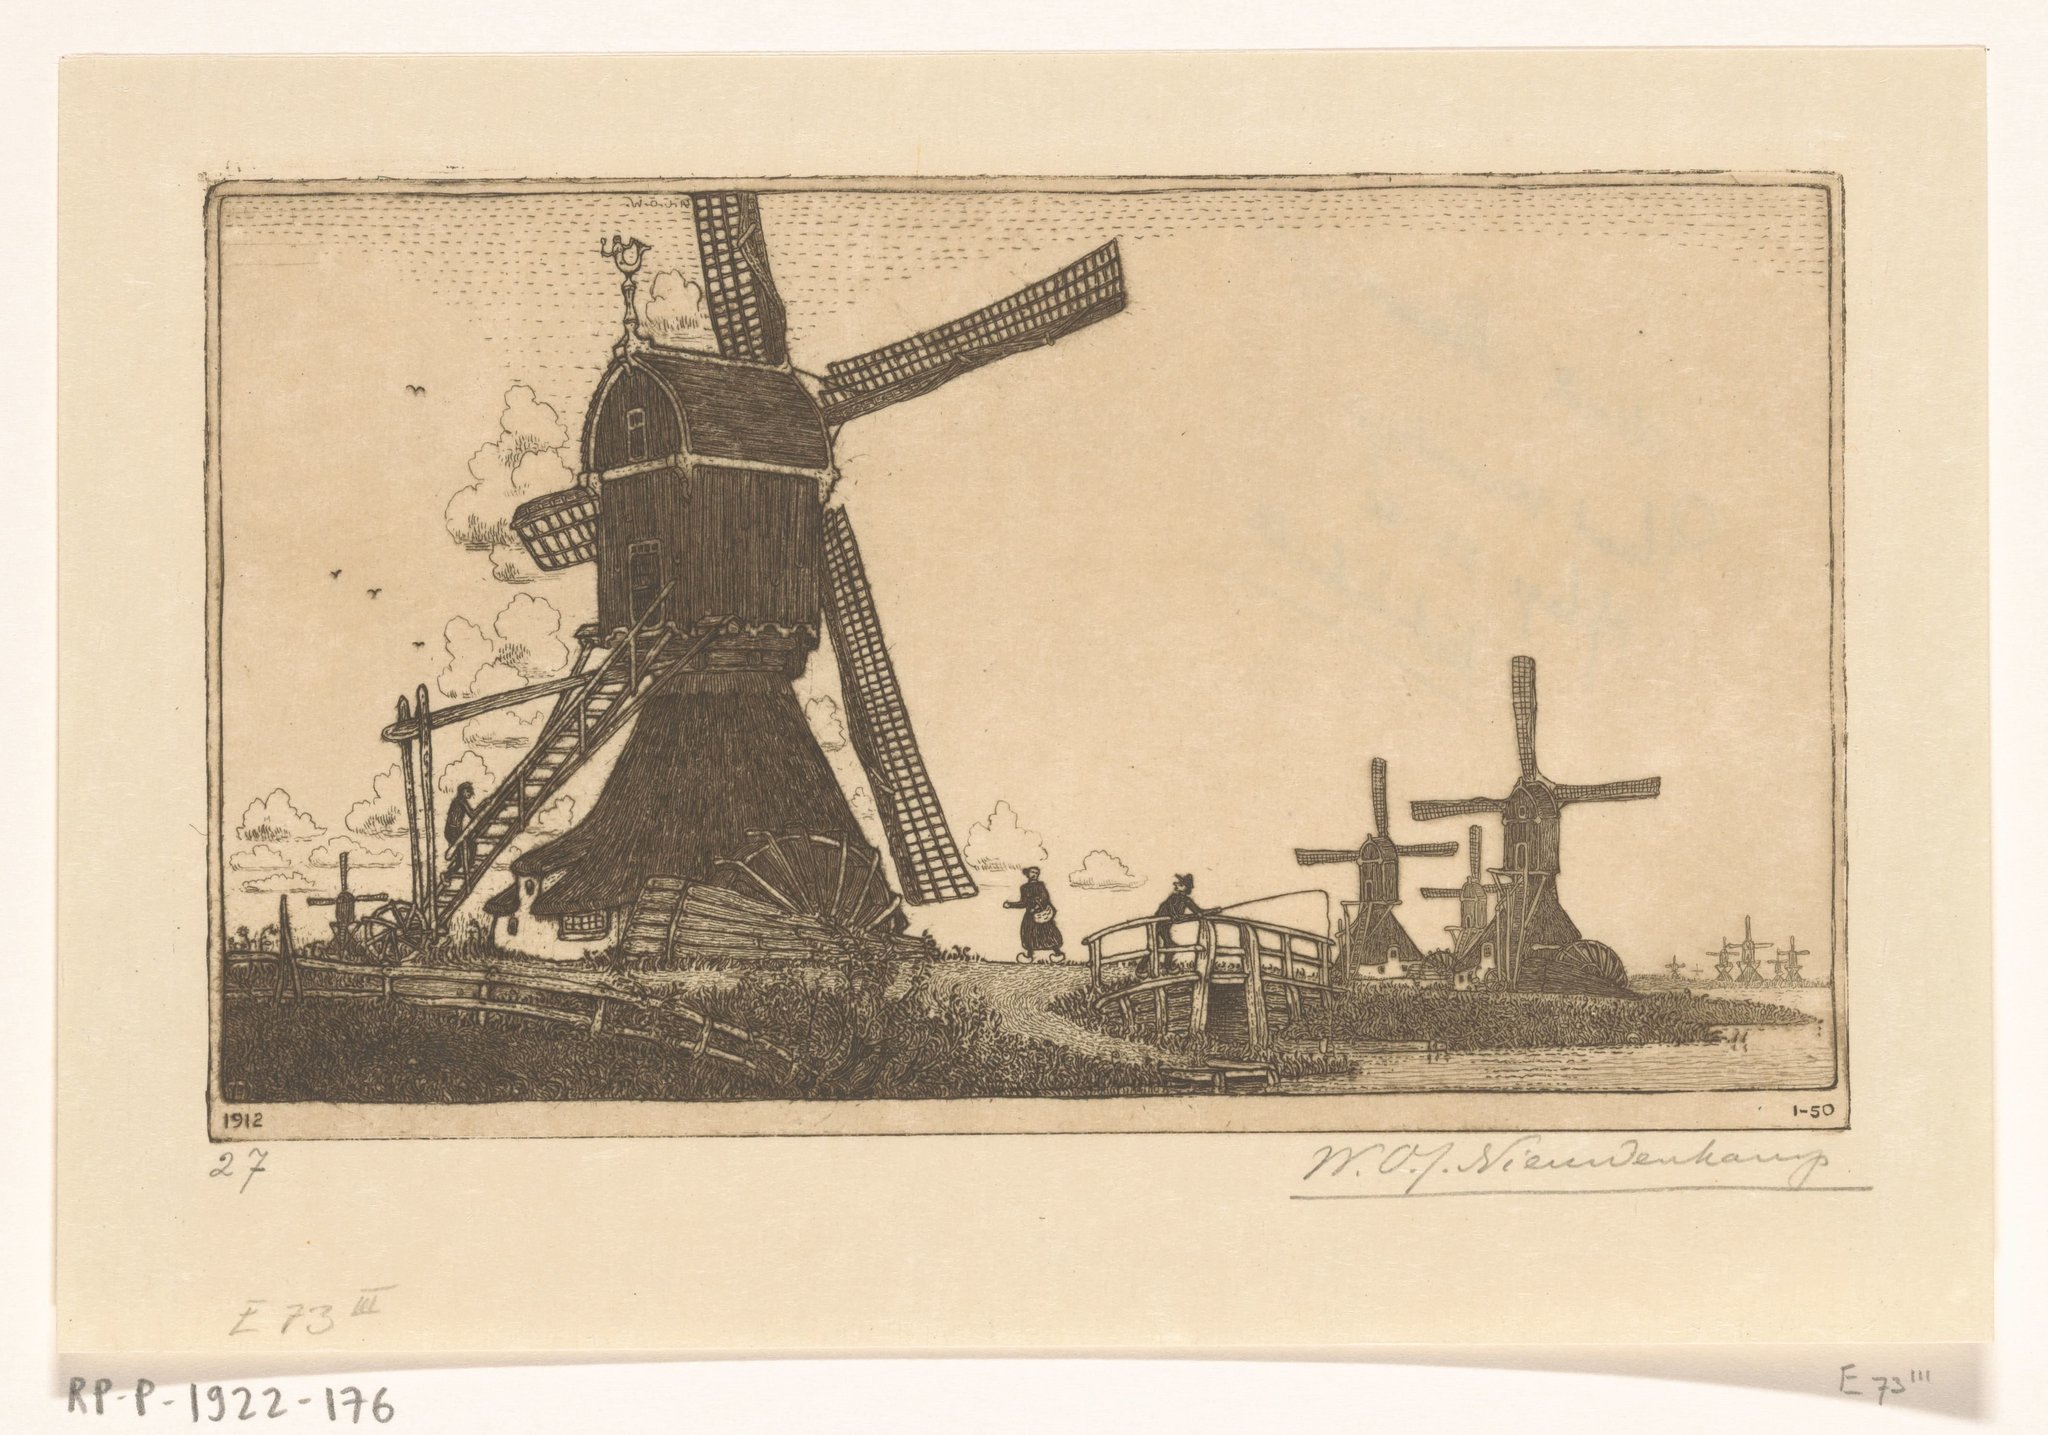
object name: print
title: Watermolens bij Gouda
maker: wijnand otto jan nieuwenkamp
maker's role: draughtsman, print maker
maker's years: 1874-1950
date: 1903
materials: paper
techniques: etching, intaglio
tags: river, windmill in landscape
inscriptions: inscription: ‘Plaat vernietigd / oplage 50 ex / uitverkocht’, collector's mark: Lugt 2228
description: In het midden een brug met daarop een vrouw op klompen en een man met een hengel. Ze kijken naar elkaar.